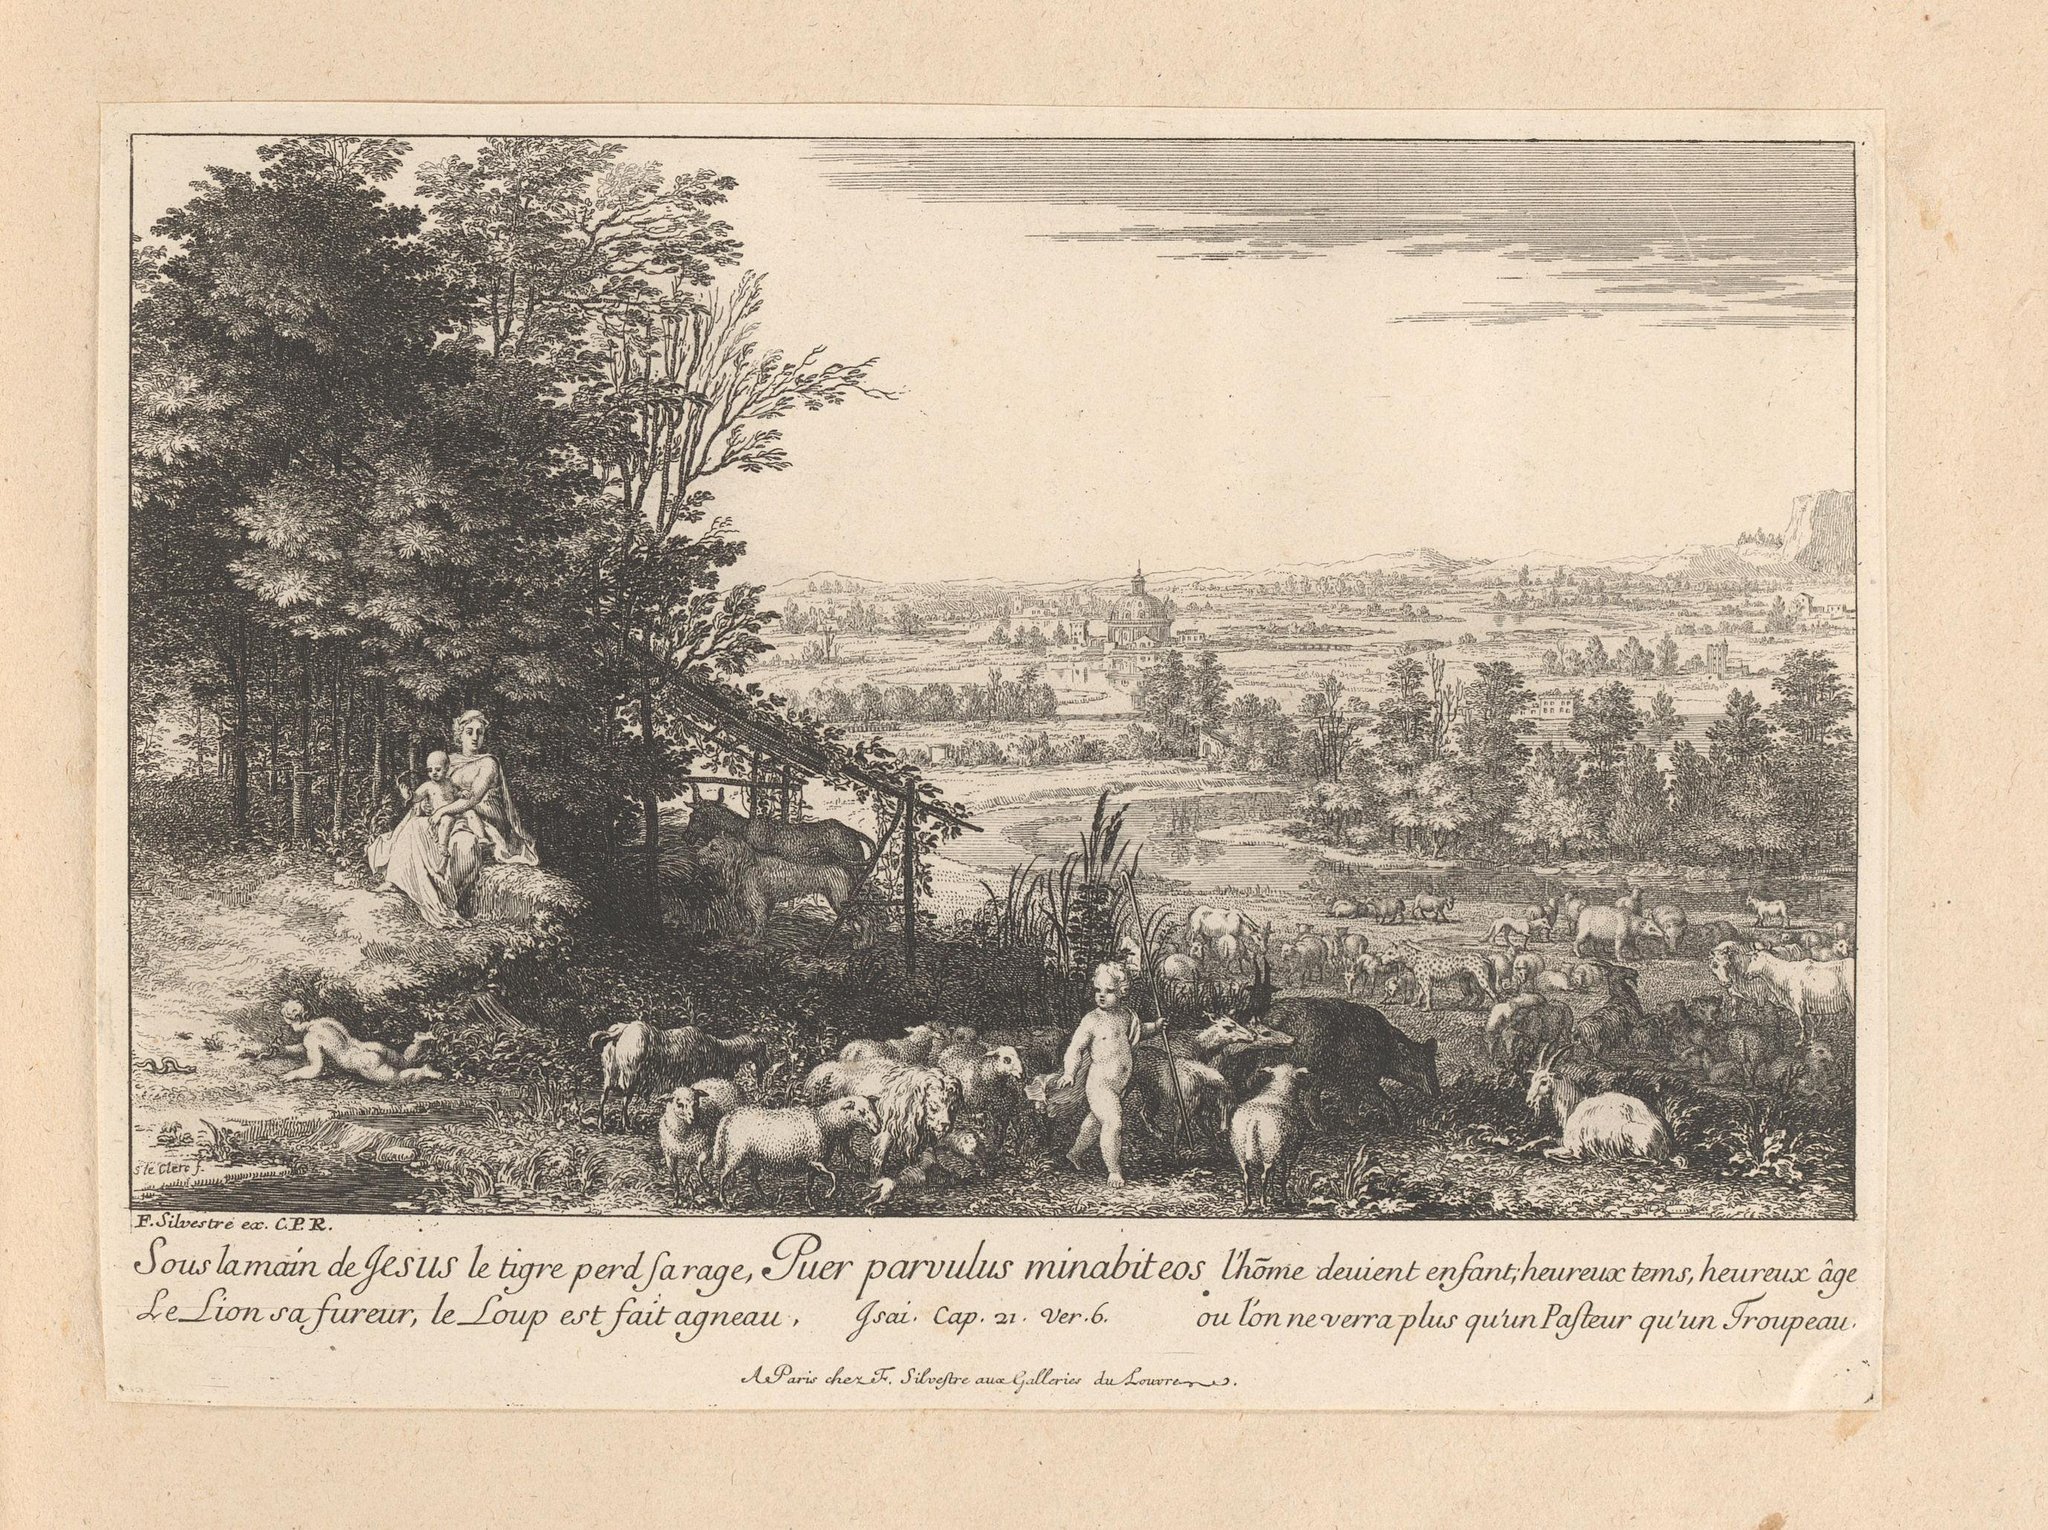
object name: print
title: Landschap met een kind als herder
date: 1695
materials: paper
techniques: etching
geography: france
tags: christ as good shepherd